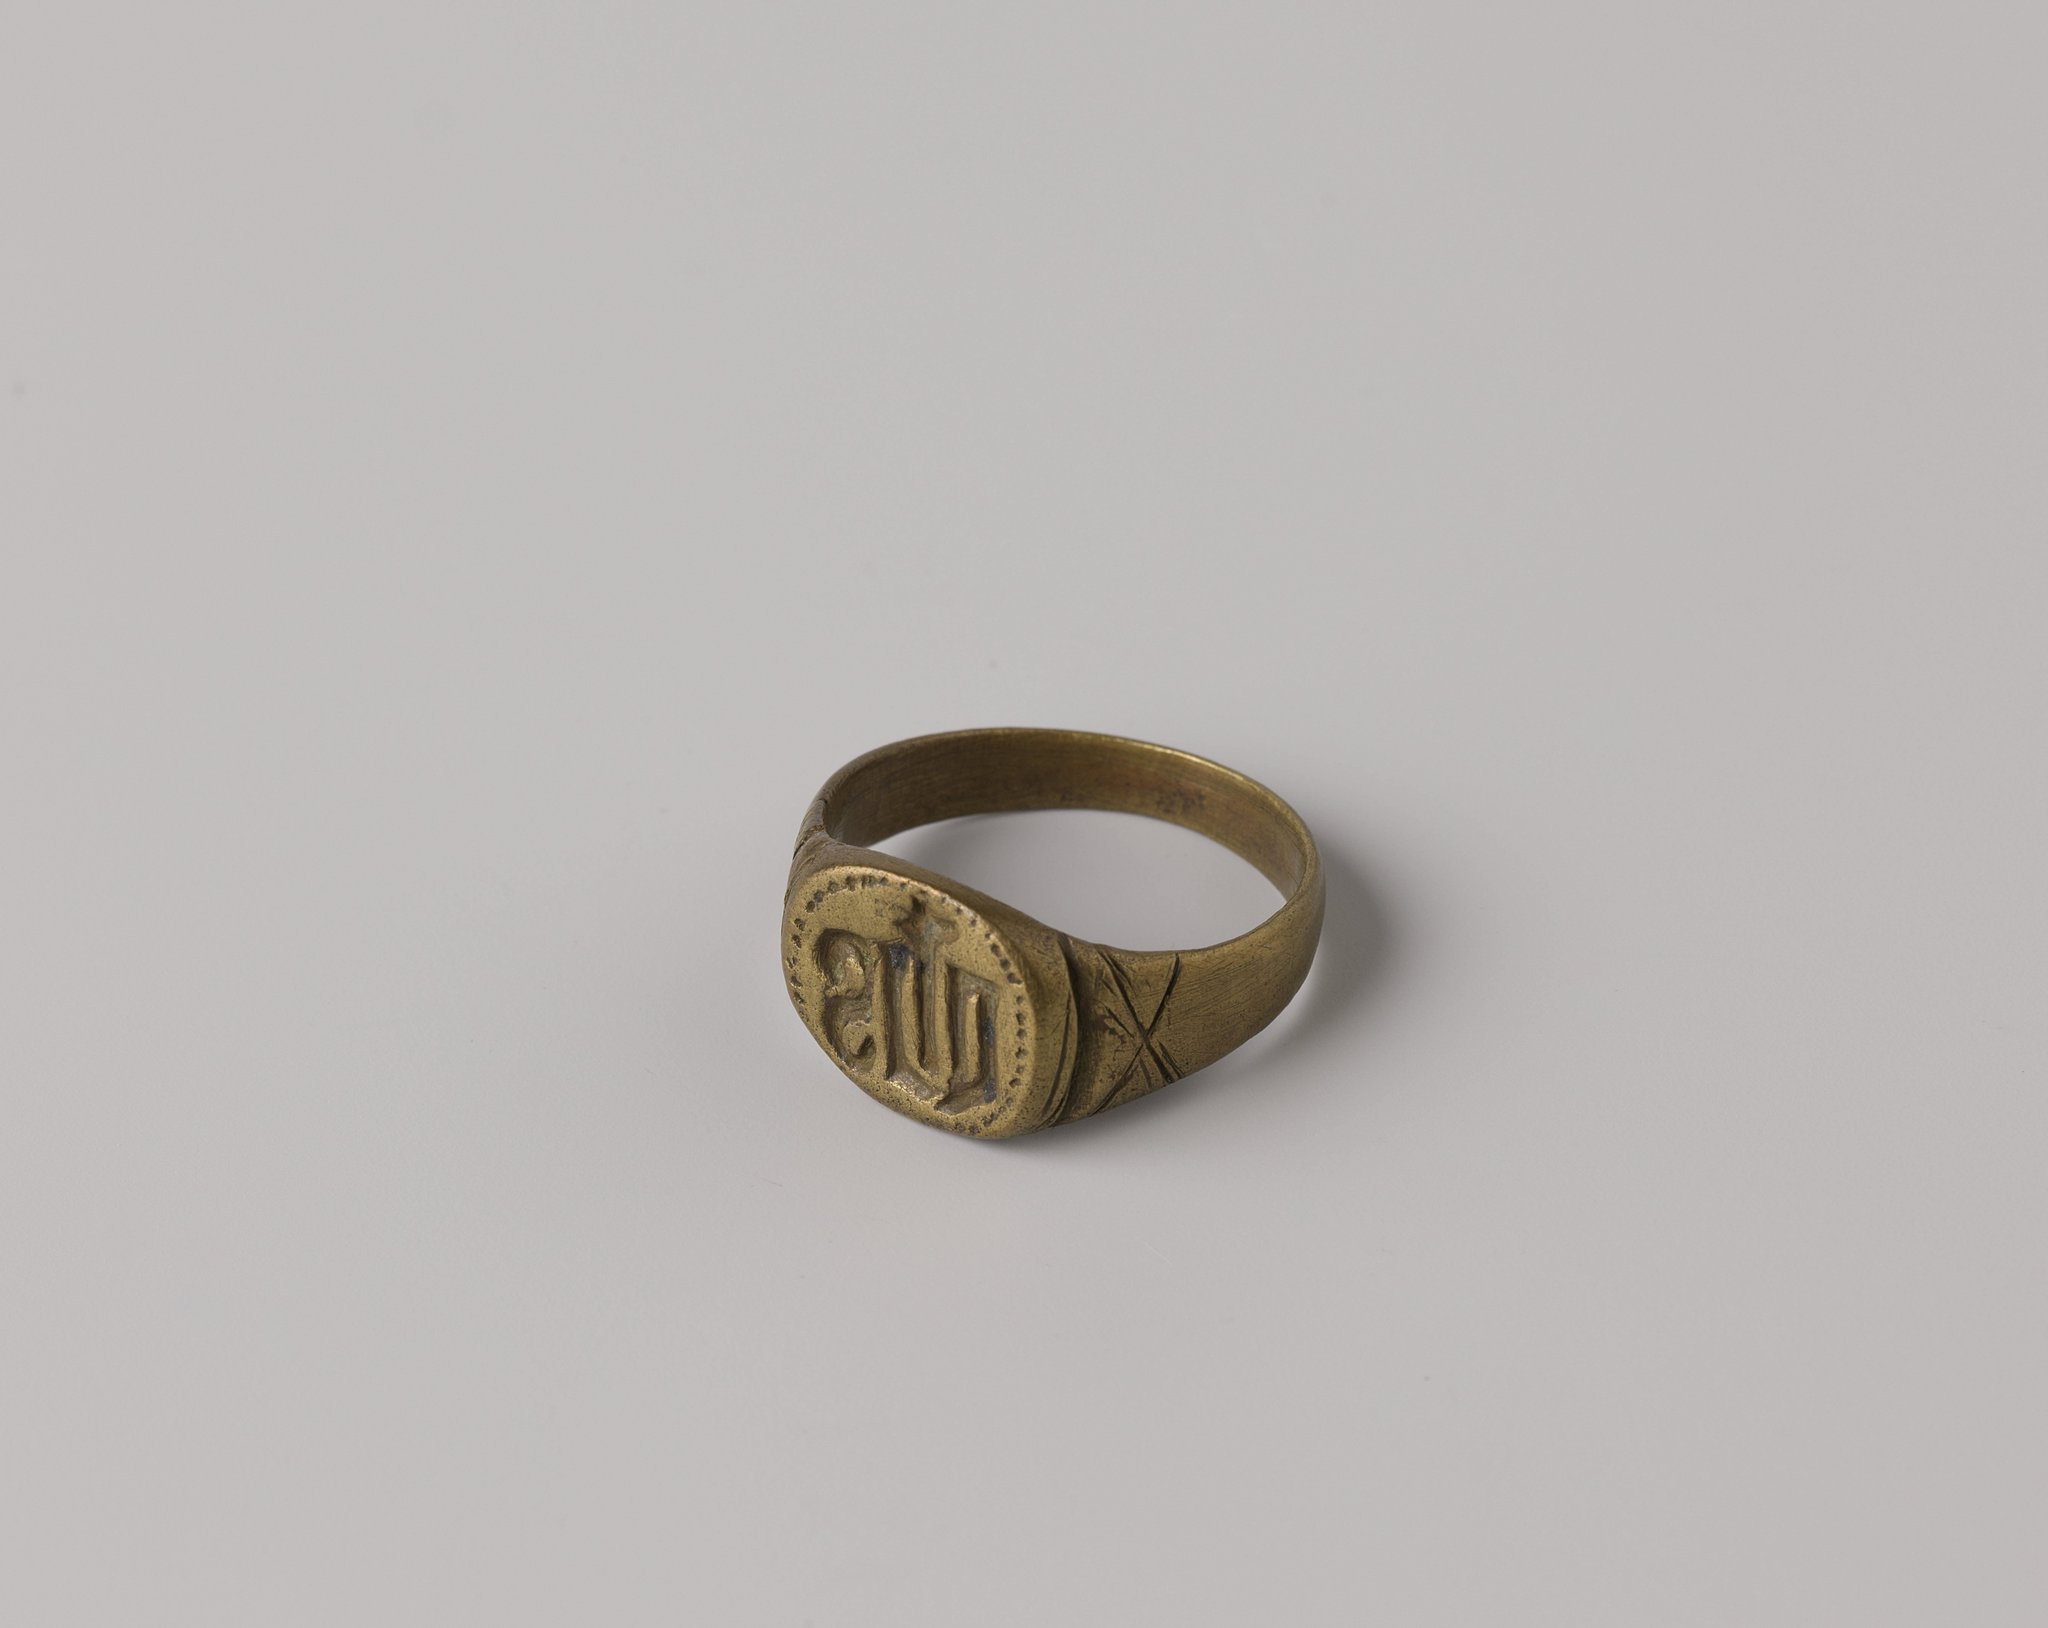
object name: ring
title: Zegelring met Gotische letters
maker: Anonymous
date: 1000-1900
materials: copper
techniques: engraving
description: Ring met ovalen zegelstempel waar in een parelrand enkele letters in spiegelschrift staan. Aan weerszijden van de stempel op de ring enkele gekruiste krassen.